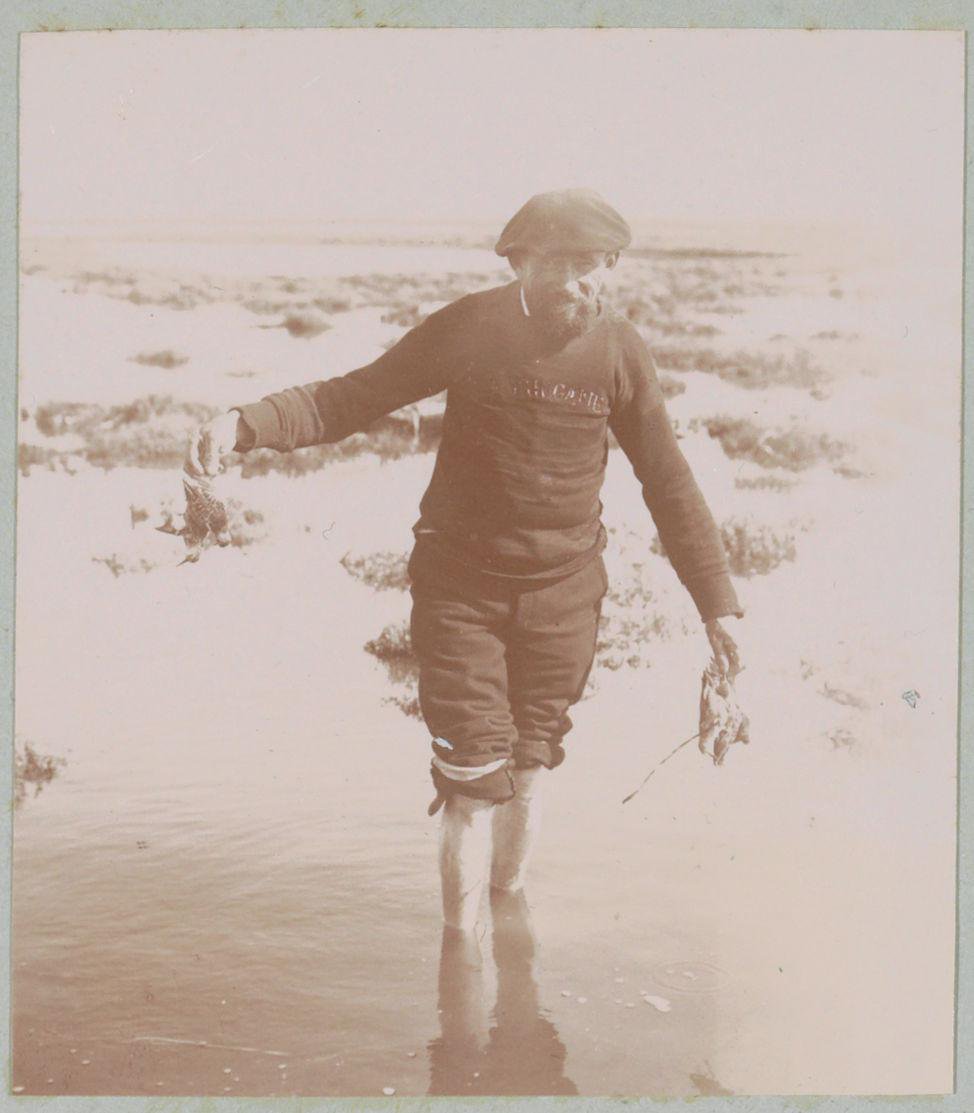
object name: photograph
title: Man waadt door water met twee gedode vogels in de hand tijdens een jachtpartij, vermoedelijk bij Arcachon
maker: delizy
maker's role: manufacturer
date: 1803-1897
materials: paper, photographic support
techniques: gelatin silver print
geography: arcachon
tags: hunter, bird hunting, spoils of the hunt, game, venison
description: Onderdeel van Fotoalbum van een Franse amateurfotograaf met opnames van uitstapjes in Frankrijk, Spanje, België, Luxemburg en Nederland, de eerste automobielen en autoraces.